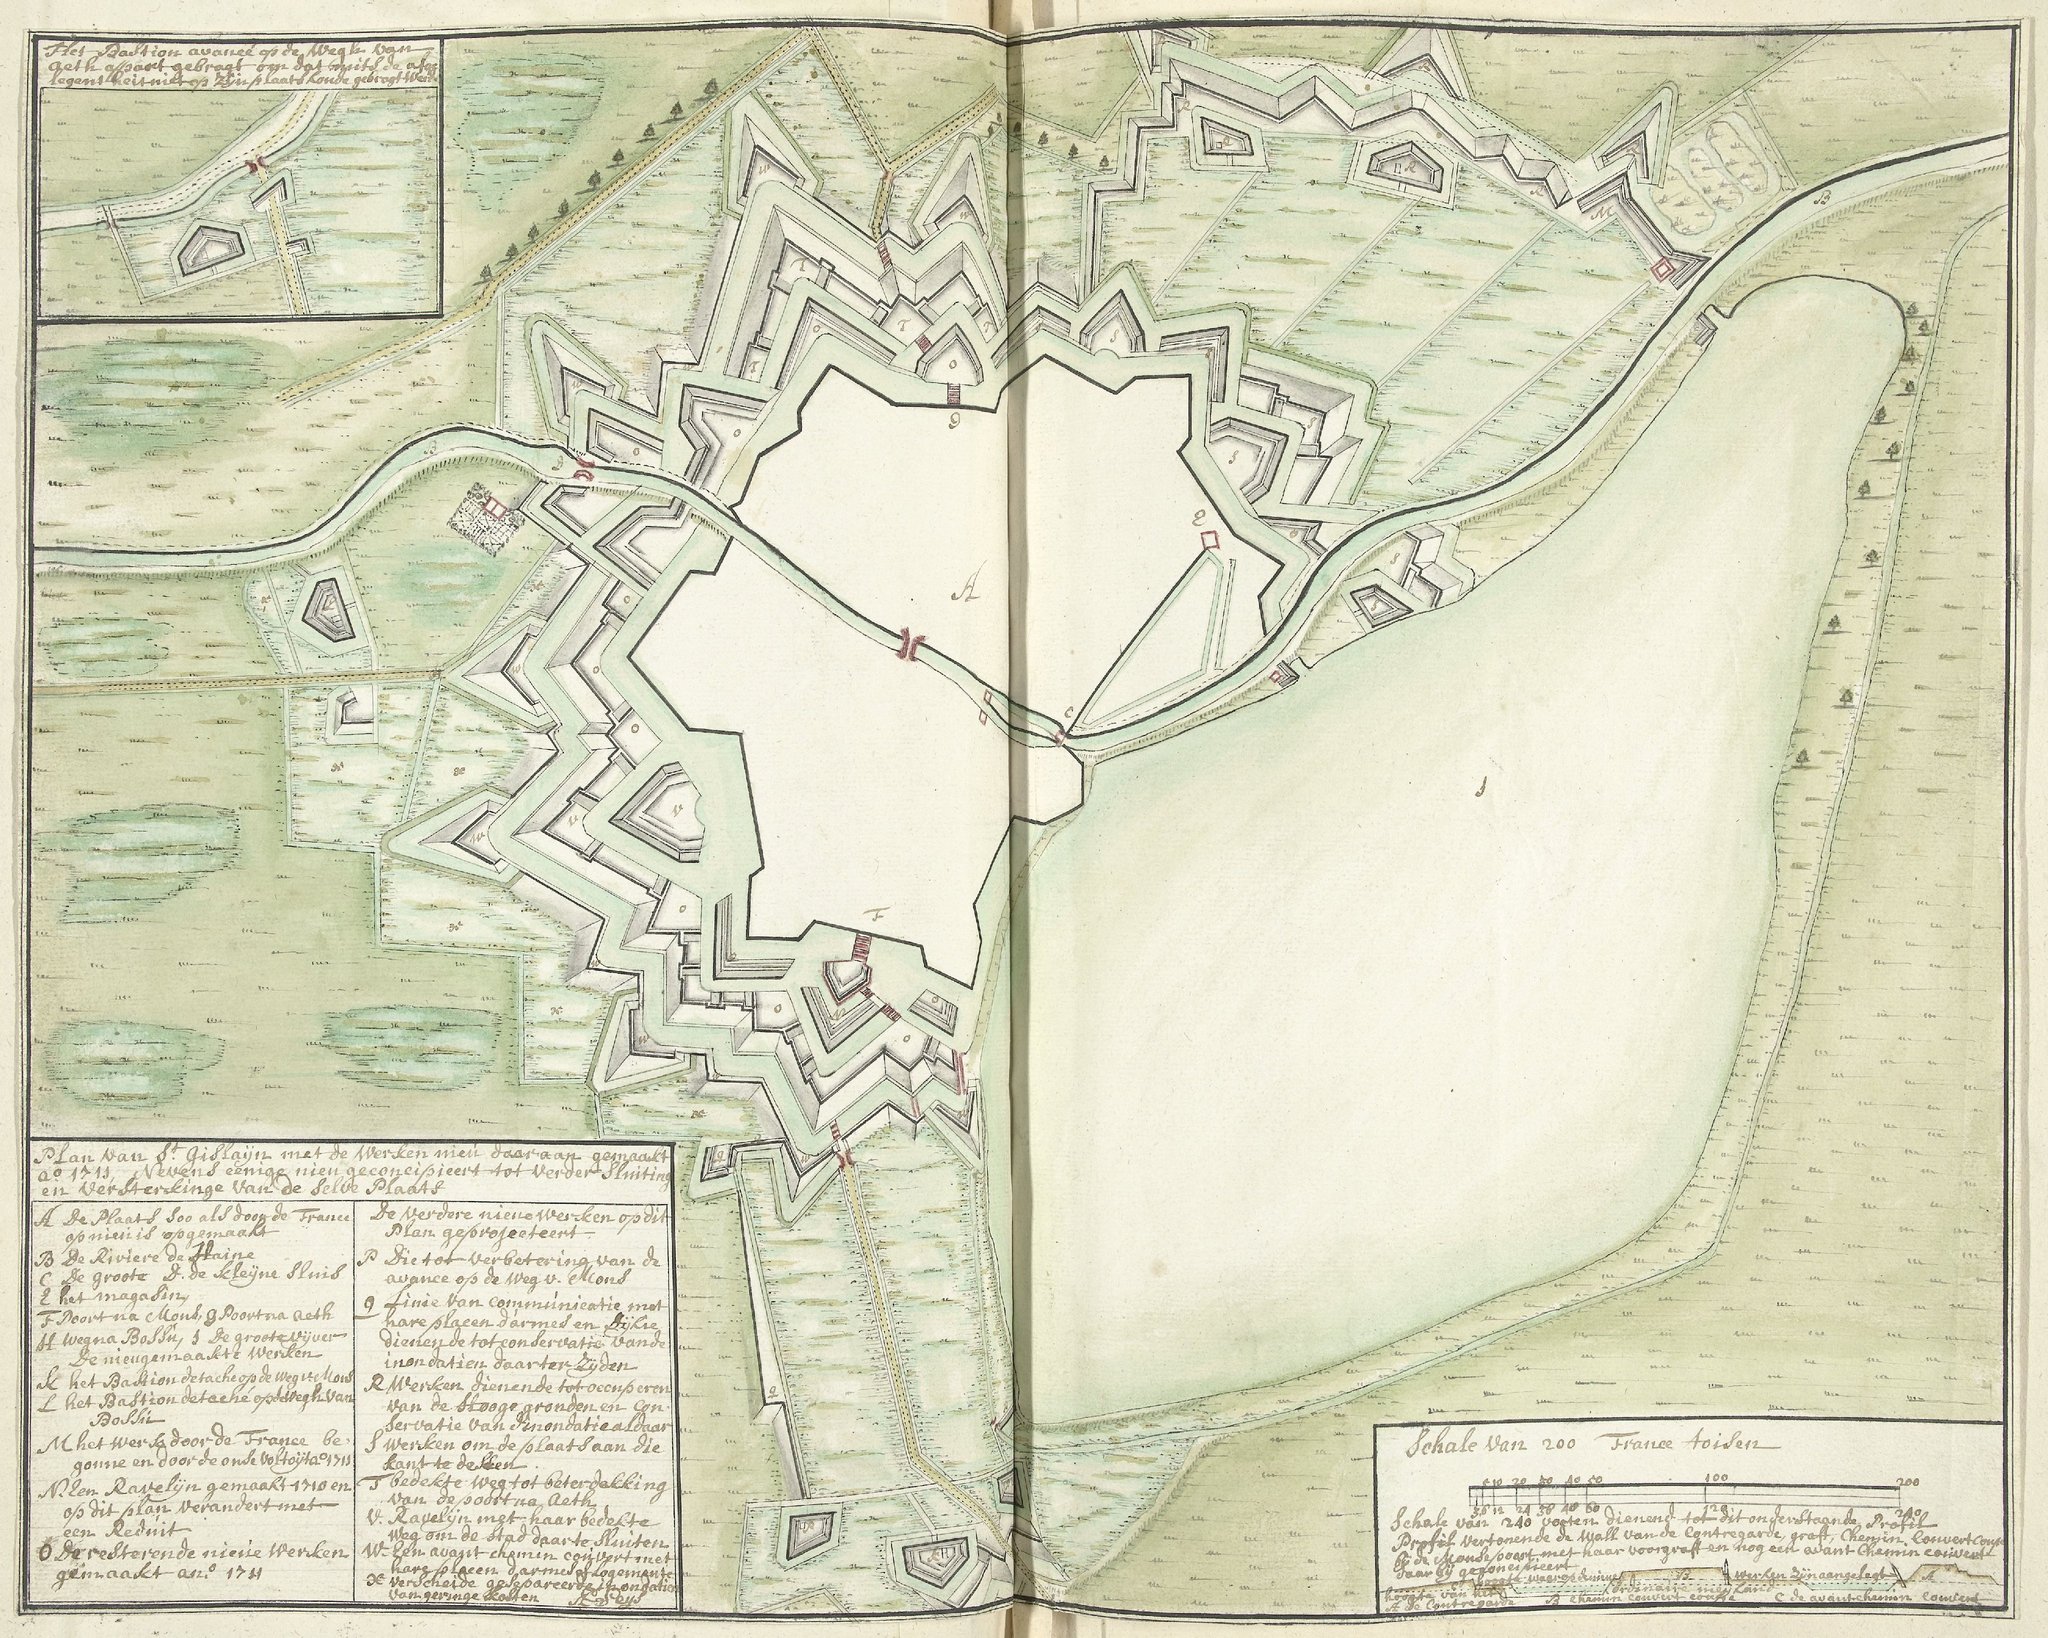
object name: drawing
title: Plattegrond van Saint-Ghislain, 1711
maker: a. seys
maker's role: draughtsman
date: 1711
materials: paper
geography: netherlands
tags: fortress, maps of cities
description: Plattegrond van de stad Saint-Ghislain met de nieuwe in 1711 aangelegde versterkingen. Linksonder de titel en legenda A-X in het Nederlands. Rechtsonder de schaalaanduiding en een doorsnede van de wallen. Bij de tekening hoort een los dubbelgevouwen blad met een verklaring van de ingenieur Seys waarom de plannen voor de nieuwe wallen zijn opgesteld. Onderdeel van een verzameling getekende plannen van versterkte plaatsen in Nederland en omringende landen ten tijde van de Spaanse Successieoorlog (deel C).